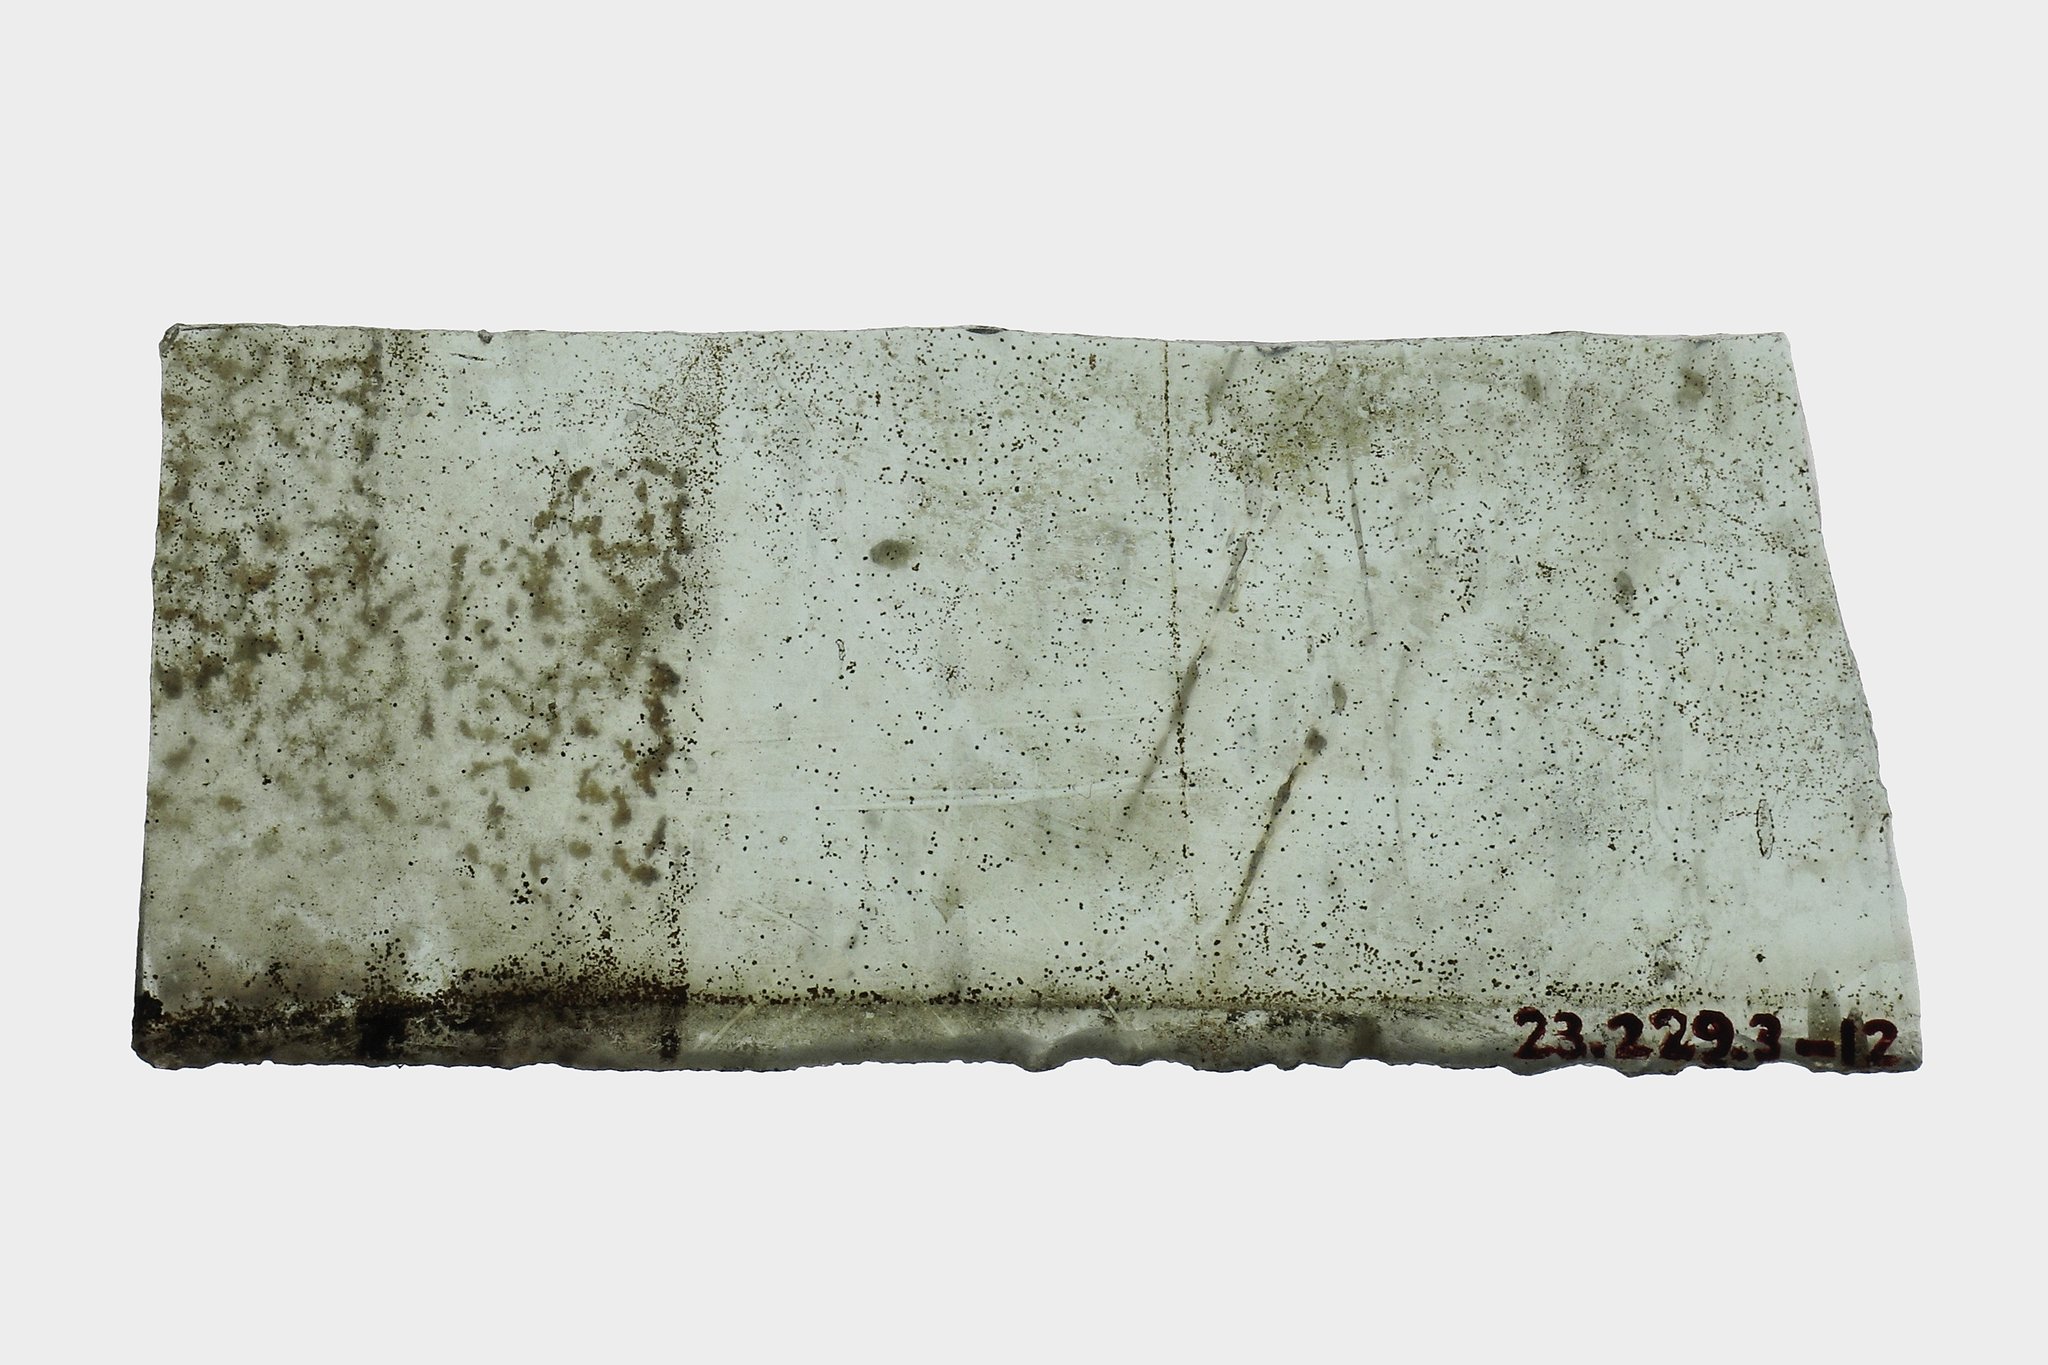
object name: fragment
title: Glass Fragment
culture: dutch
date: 1601-1700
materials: glass